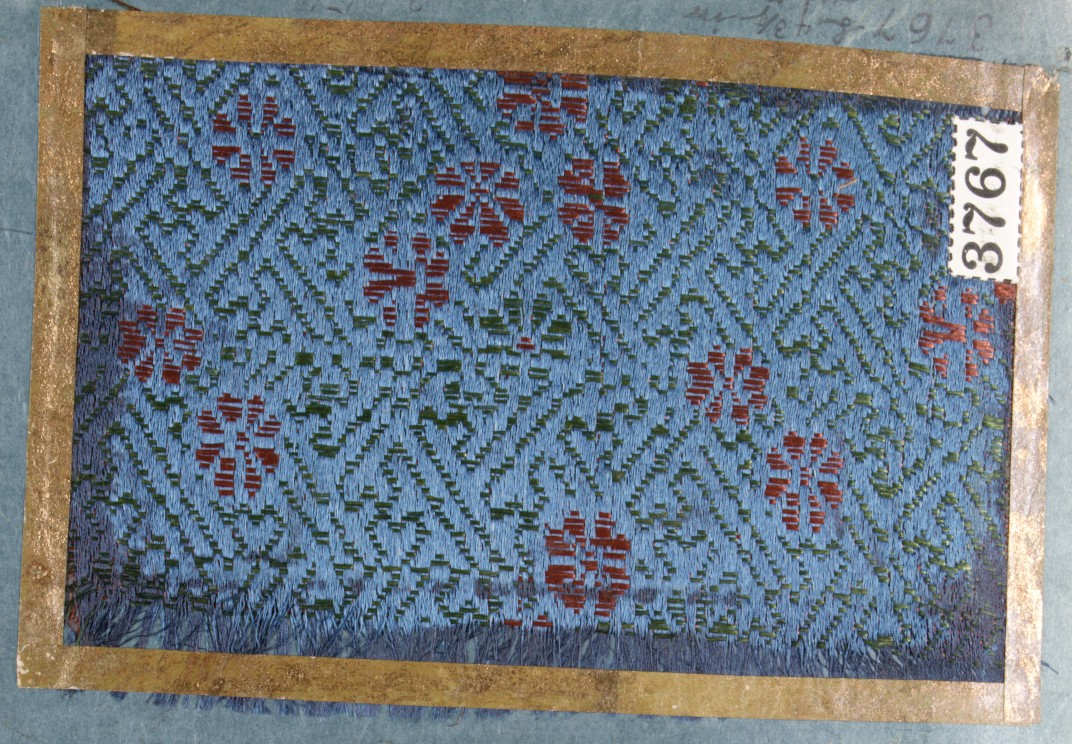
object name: sample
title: Textile Sample from Sample Book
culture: japanese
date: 1801-1900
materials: silk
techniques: tapestry